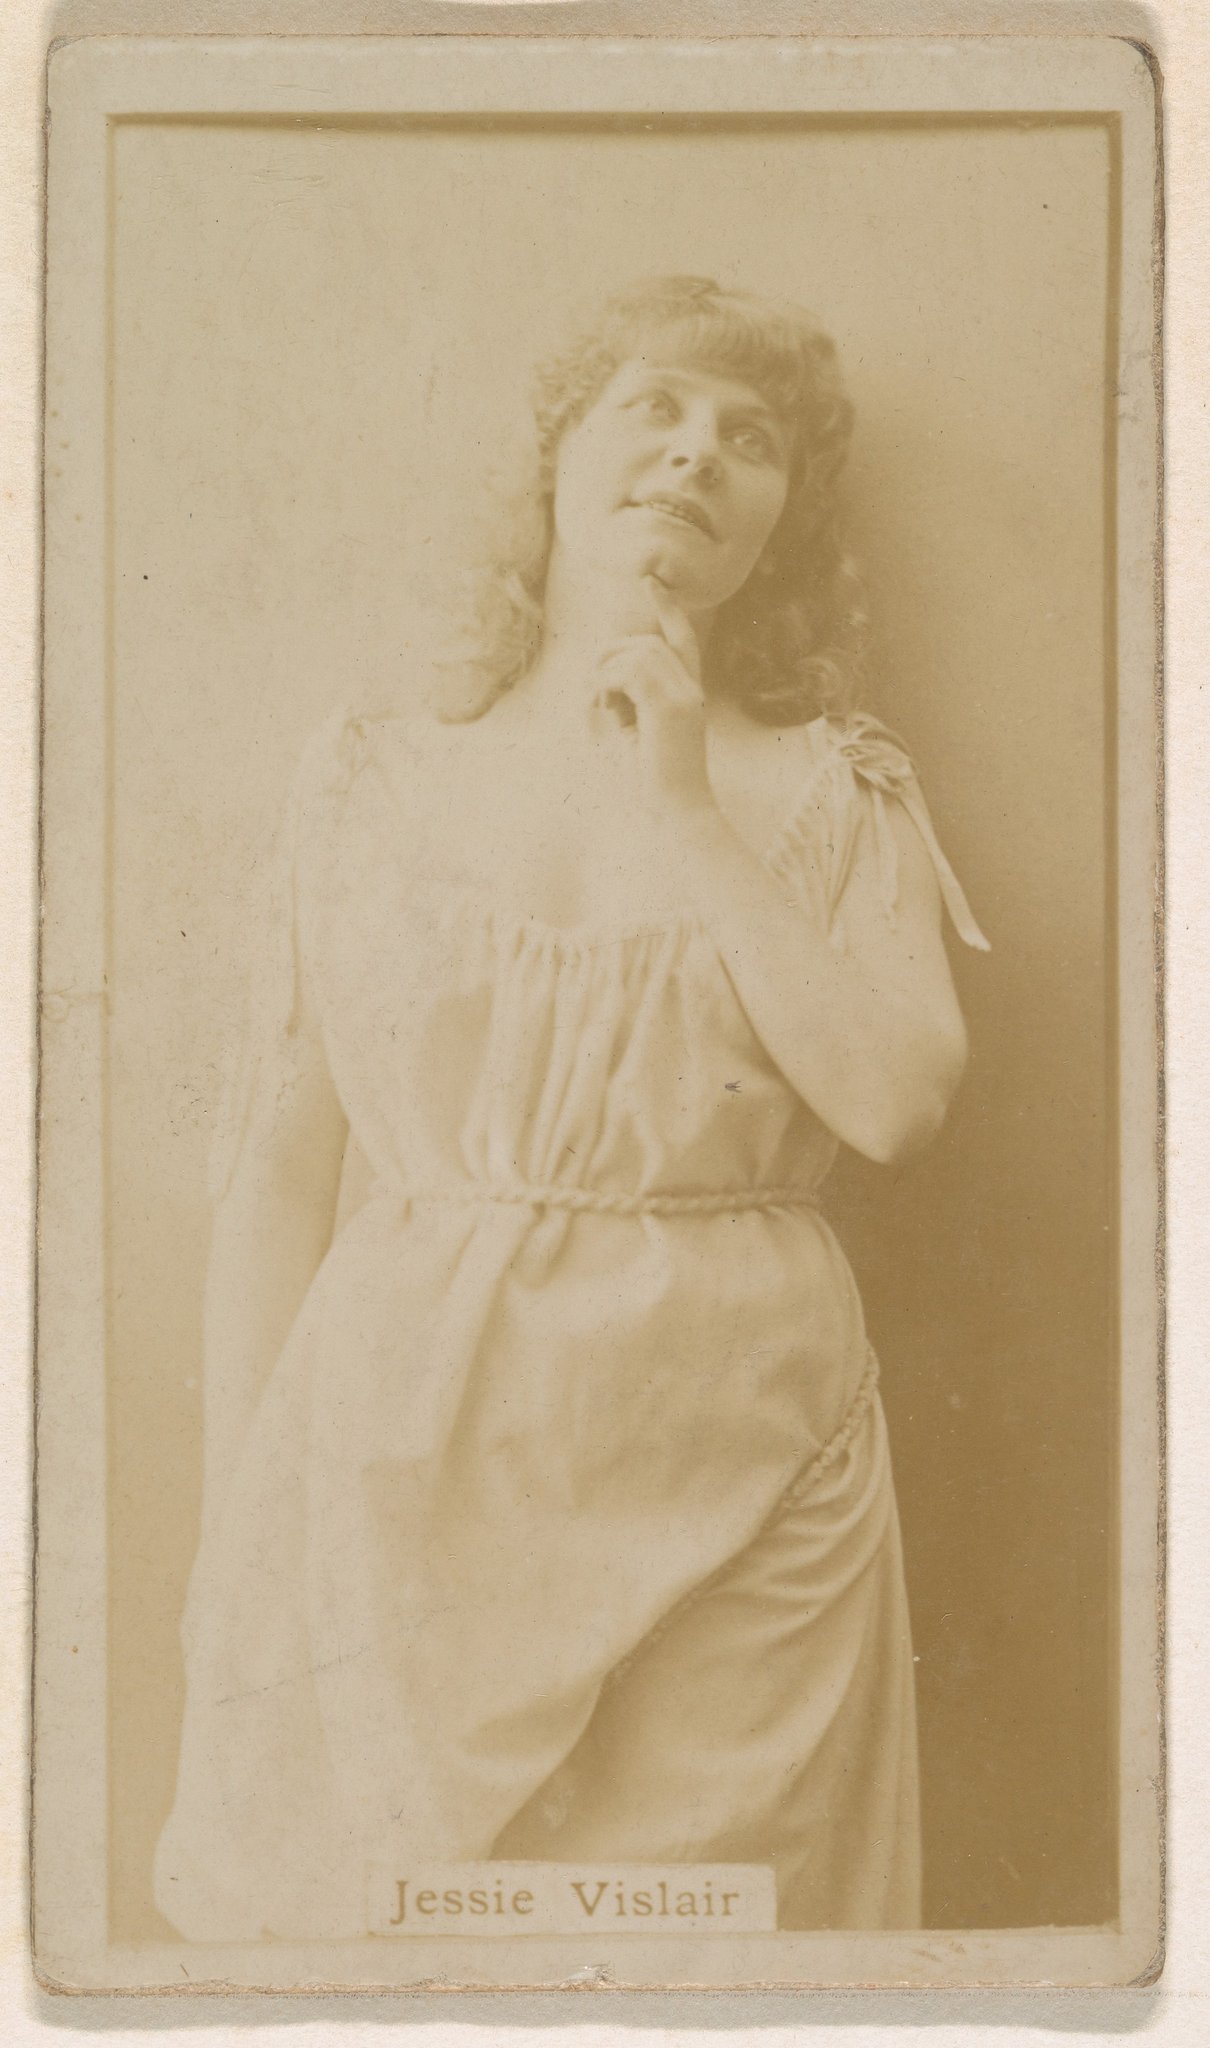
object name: photograph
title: Jessie Vislair, from the Actresses series (N245) issued by Kinney Brothers to promote Sweet Caporal Cigarettes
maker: kinney brothers tobacco company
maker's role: publisher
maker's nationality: american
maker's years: 1869-2011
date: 1890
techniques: albumen silver print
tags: portraits,women,actresses